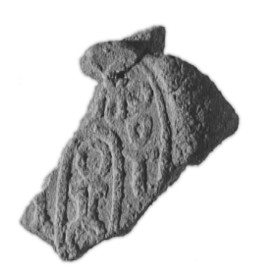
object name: sealing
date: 2030-1640 BCE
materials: clay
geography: egypt